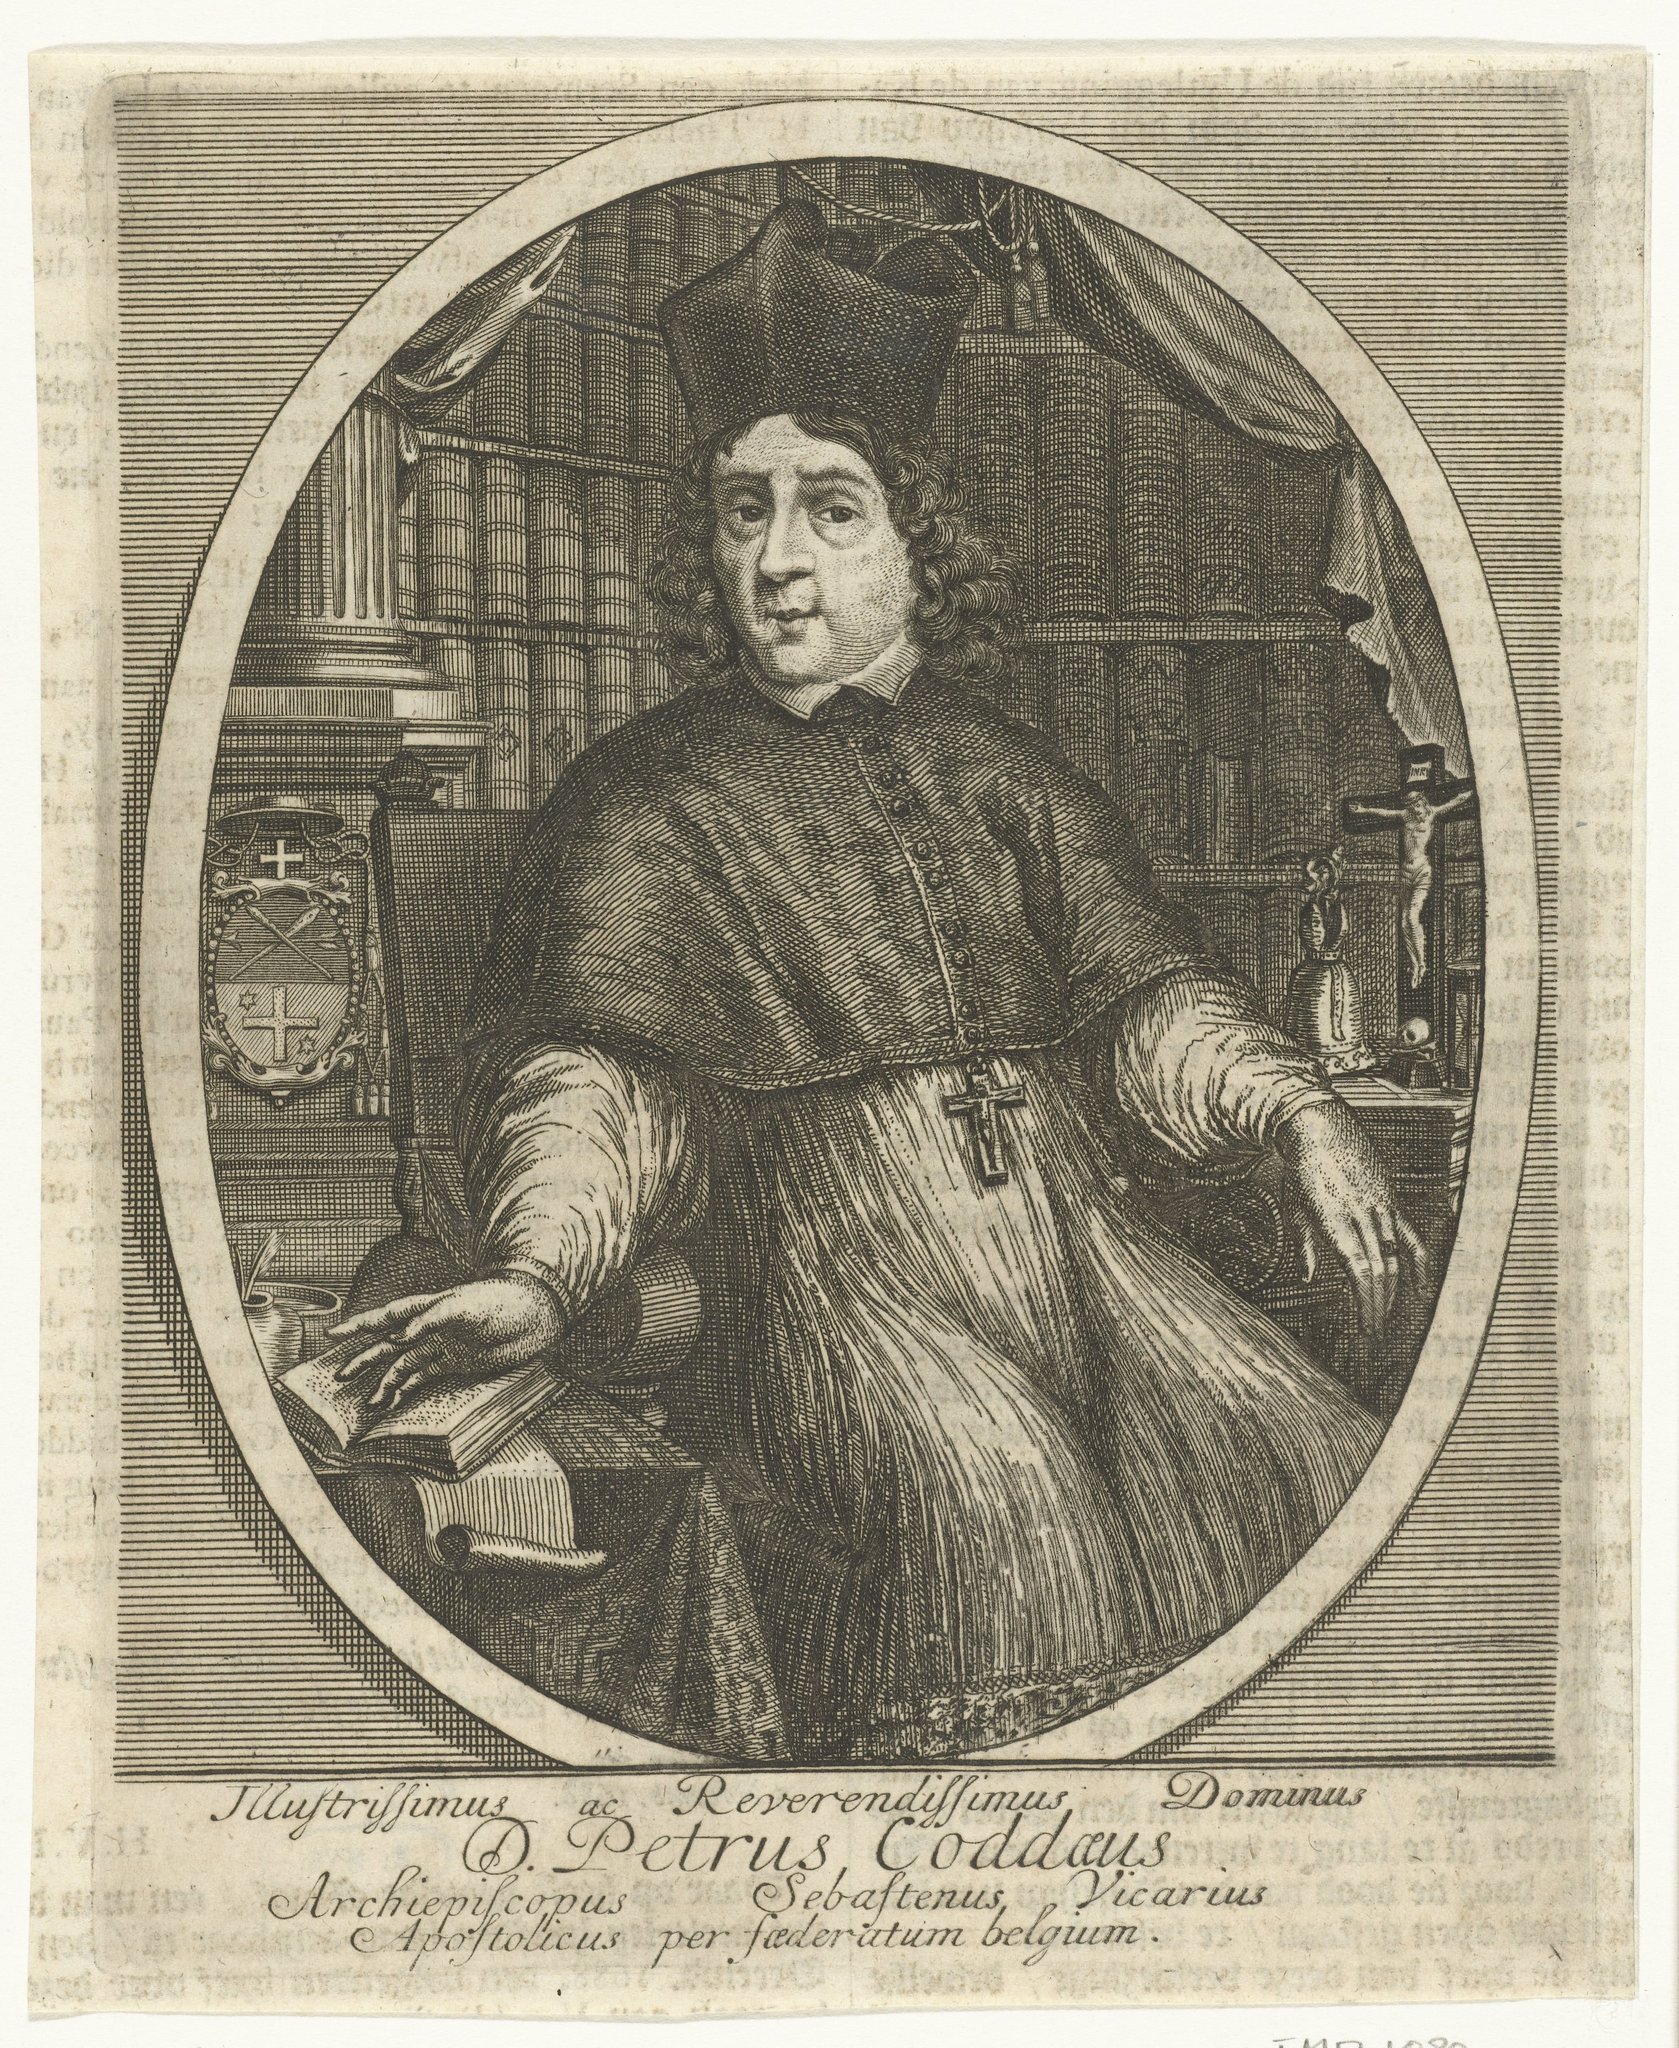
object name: print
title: Portret van apostolisch vicaris Petrus Codde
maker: françois van bleyswijck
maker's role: draughtsman, print maker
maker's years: 1671-1746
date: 1681-1726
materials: paper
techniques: engraving, etching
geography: leiden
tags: utrecht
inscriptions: collector's mark: Lugt 2228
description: Prent uit: Heussen, Hugo Franciscus van & Hugo van Rijn, Kerkelijke historie en outheden der Zeven Vereenigde Provincien, 6 delen, Leiden, Dirk Haak & Samuel Luchtmans & Johan Arnold Langerak, 1726